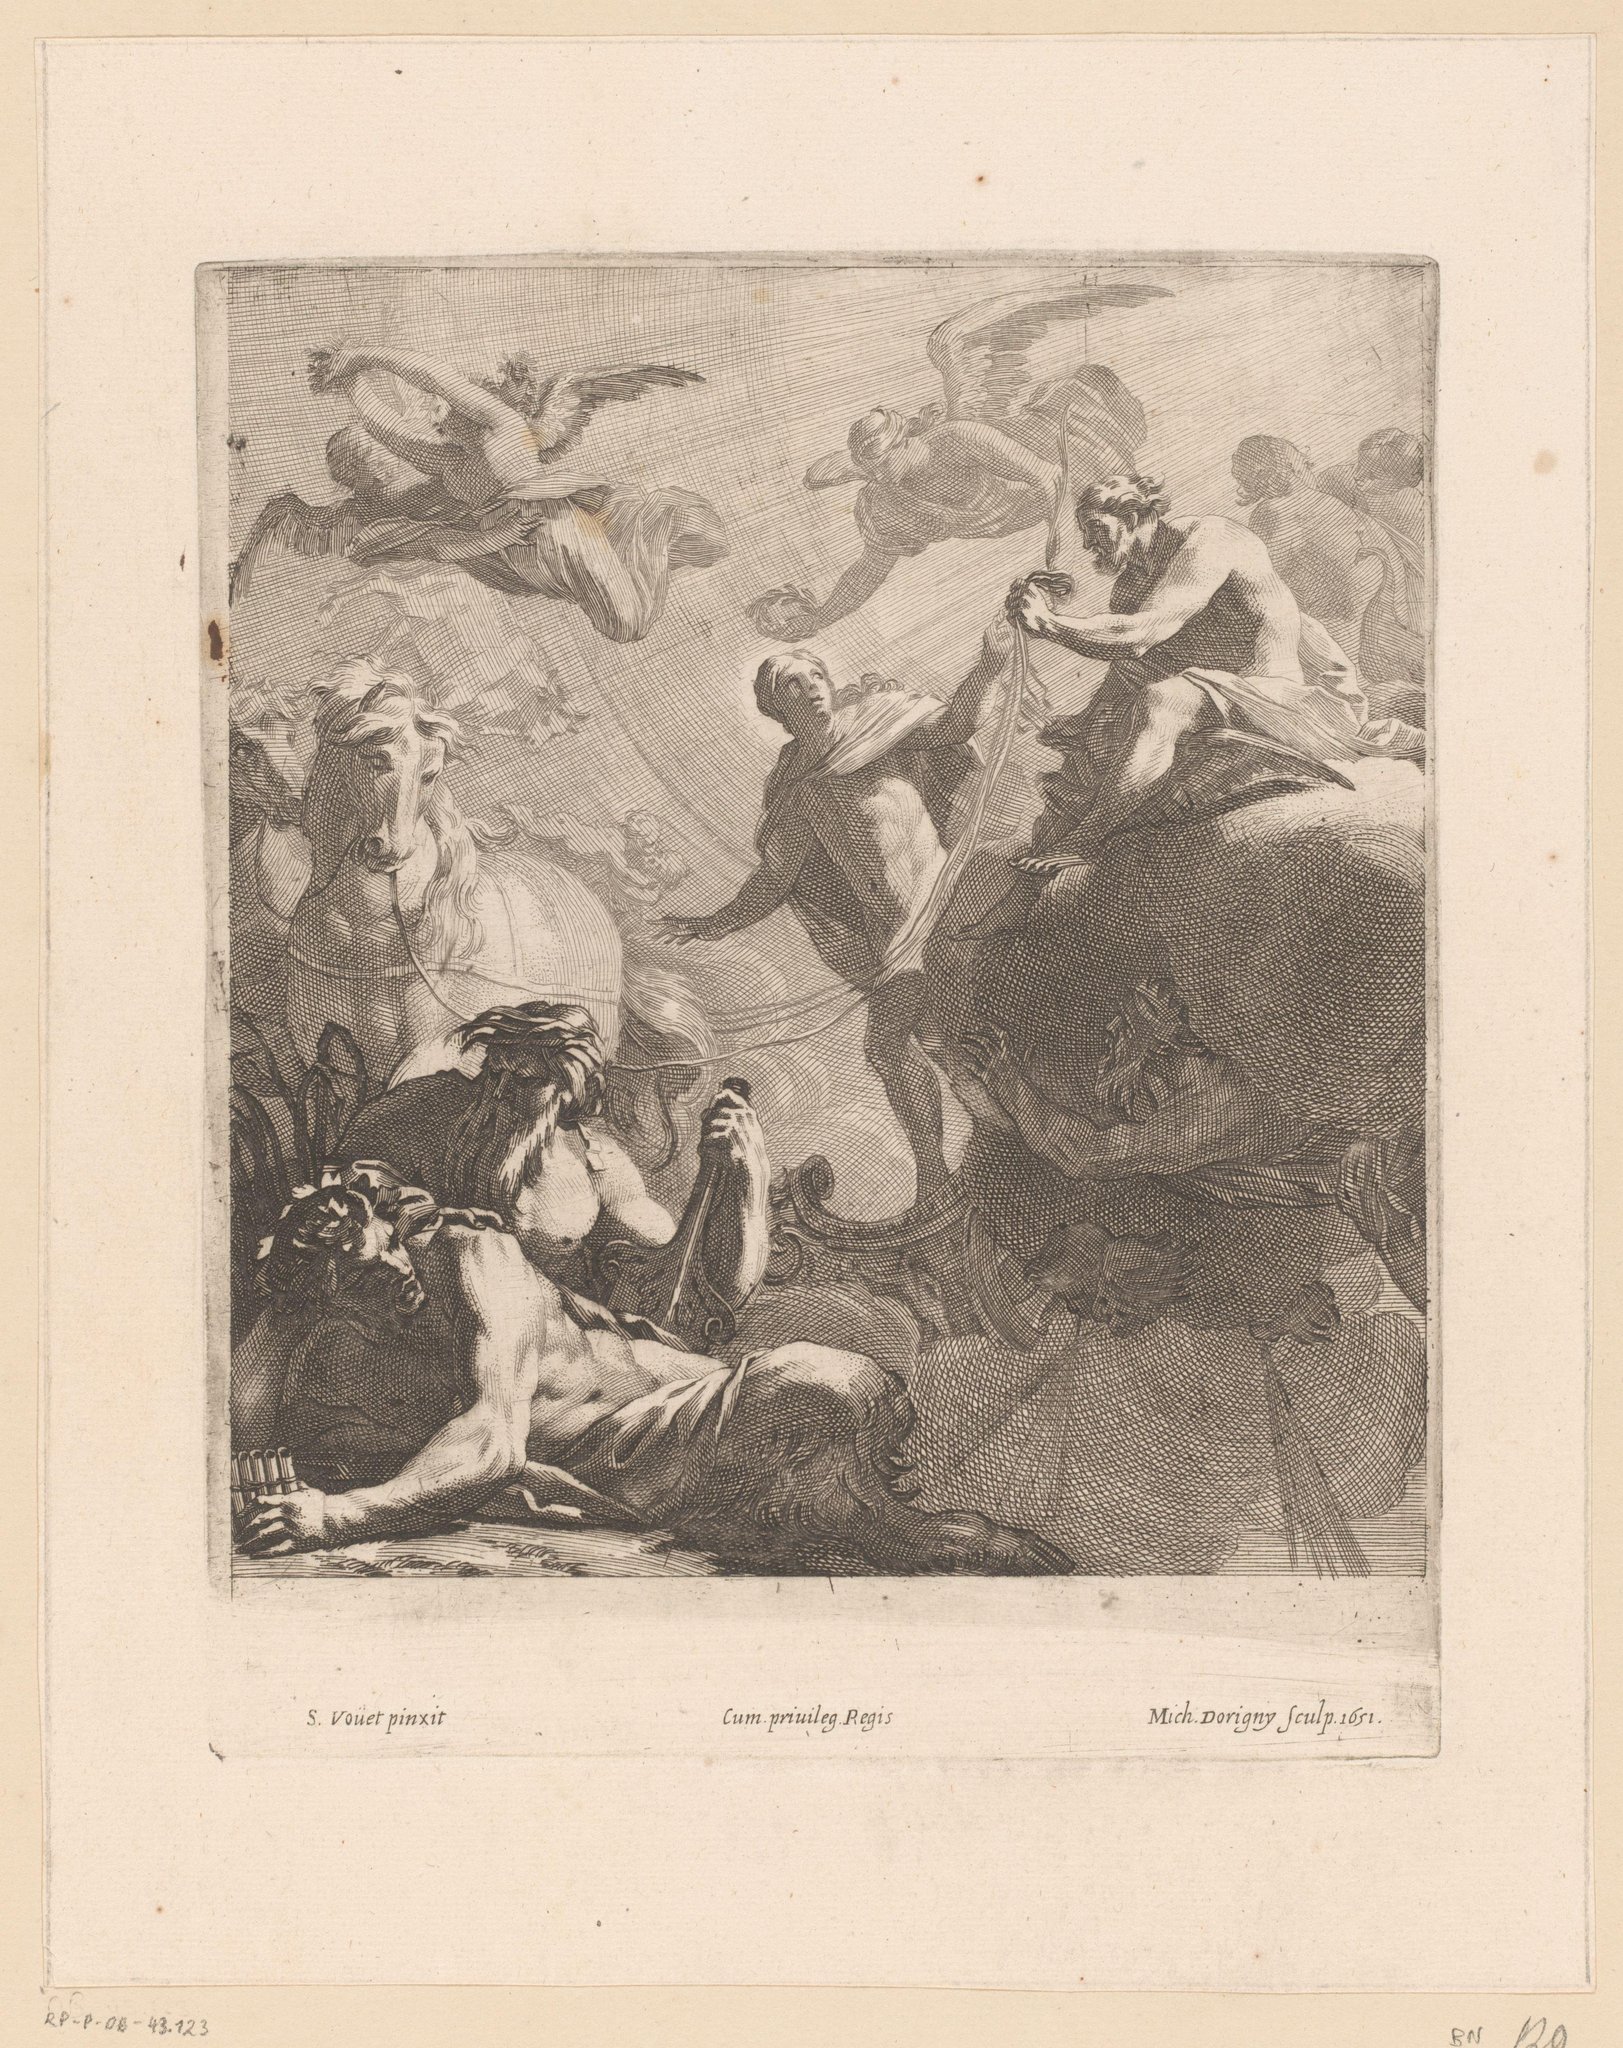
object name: print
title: Jupiter en Phaëton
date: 1651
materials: paper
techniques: engraving, etching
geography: france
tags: story of phaethon and the chariot of the sun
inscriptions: collector's mark: Lugt 240